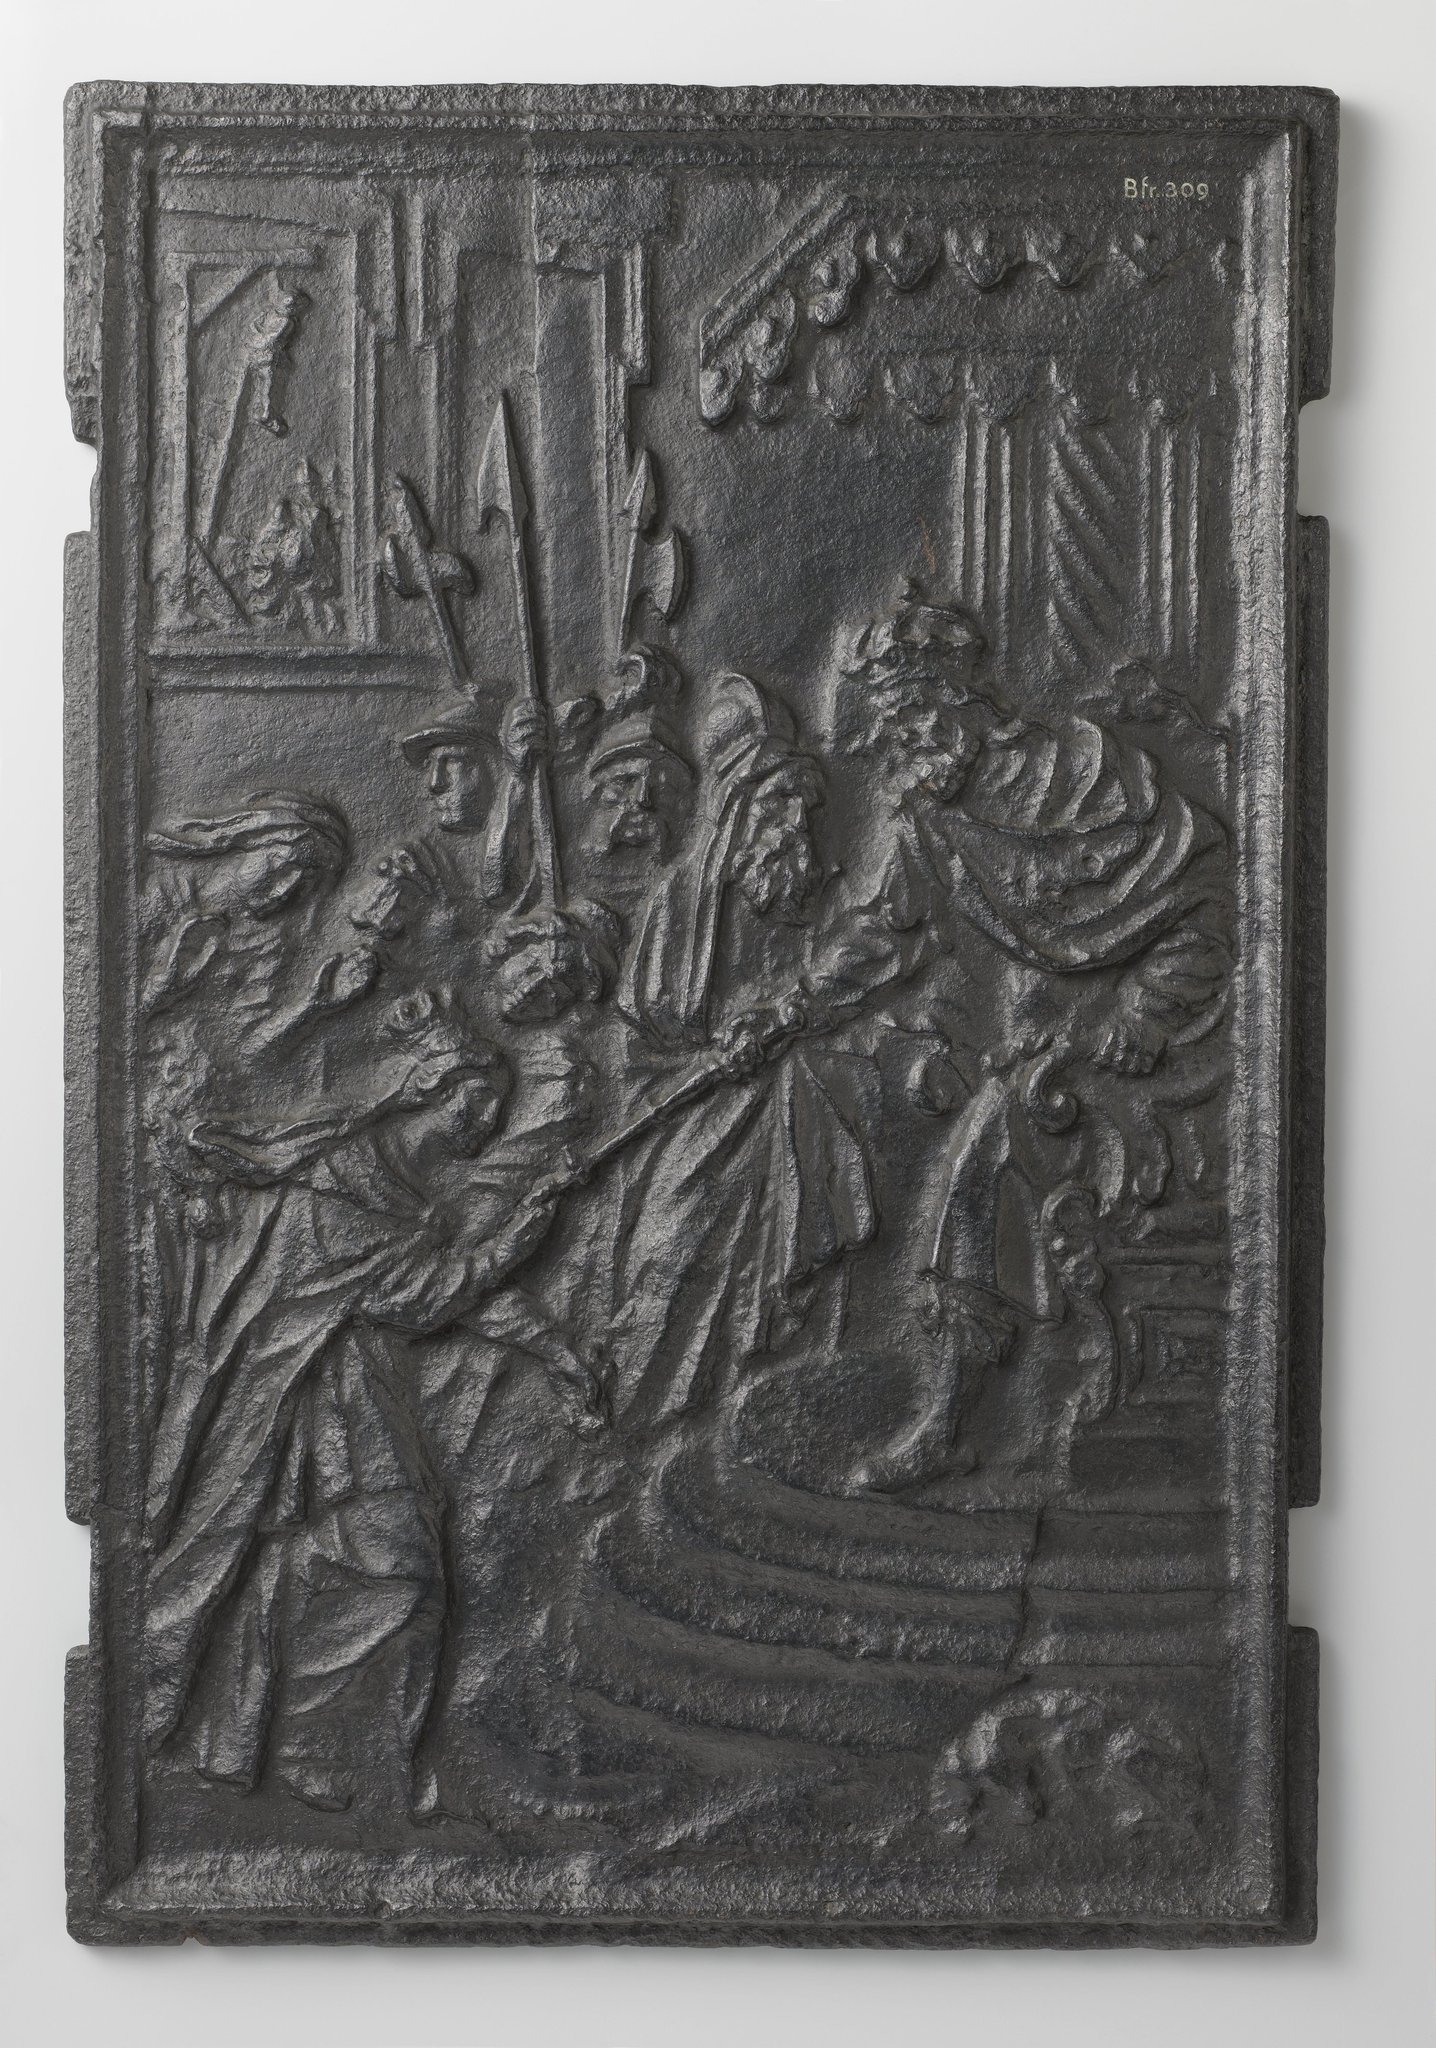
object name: stove plate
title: Kachelplaat met Esther voor koning Ahasveros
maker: Anonymous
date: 1650-1700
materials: iron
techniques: casting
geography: germany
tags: esther before ahasuerus (esther 5:1-4)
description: Kachelplaat van gietijzer met een voorstelling van Esther, die buigt voor koning Ahasveros, die iets van zijn troon opstaat en zijn scepter naar haar uitsteekt. Achter Esther staan enkele dienstvrouwen en soldaten. Direct naast de troon staat Mordechai. In een doorkijk linksachter is Haman te zien, gehangen aan de galg.